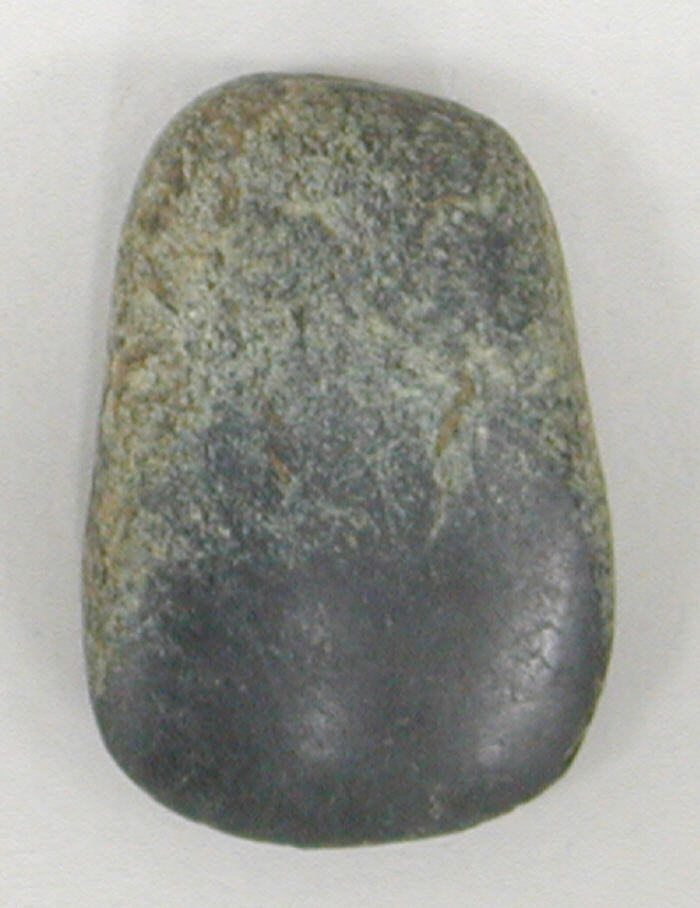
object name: chisel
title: Stone Chisel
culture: mexican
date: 1501-1600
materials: stone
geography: mexico